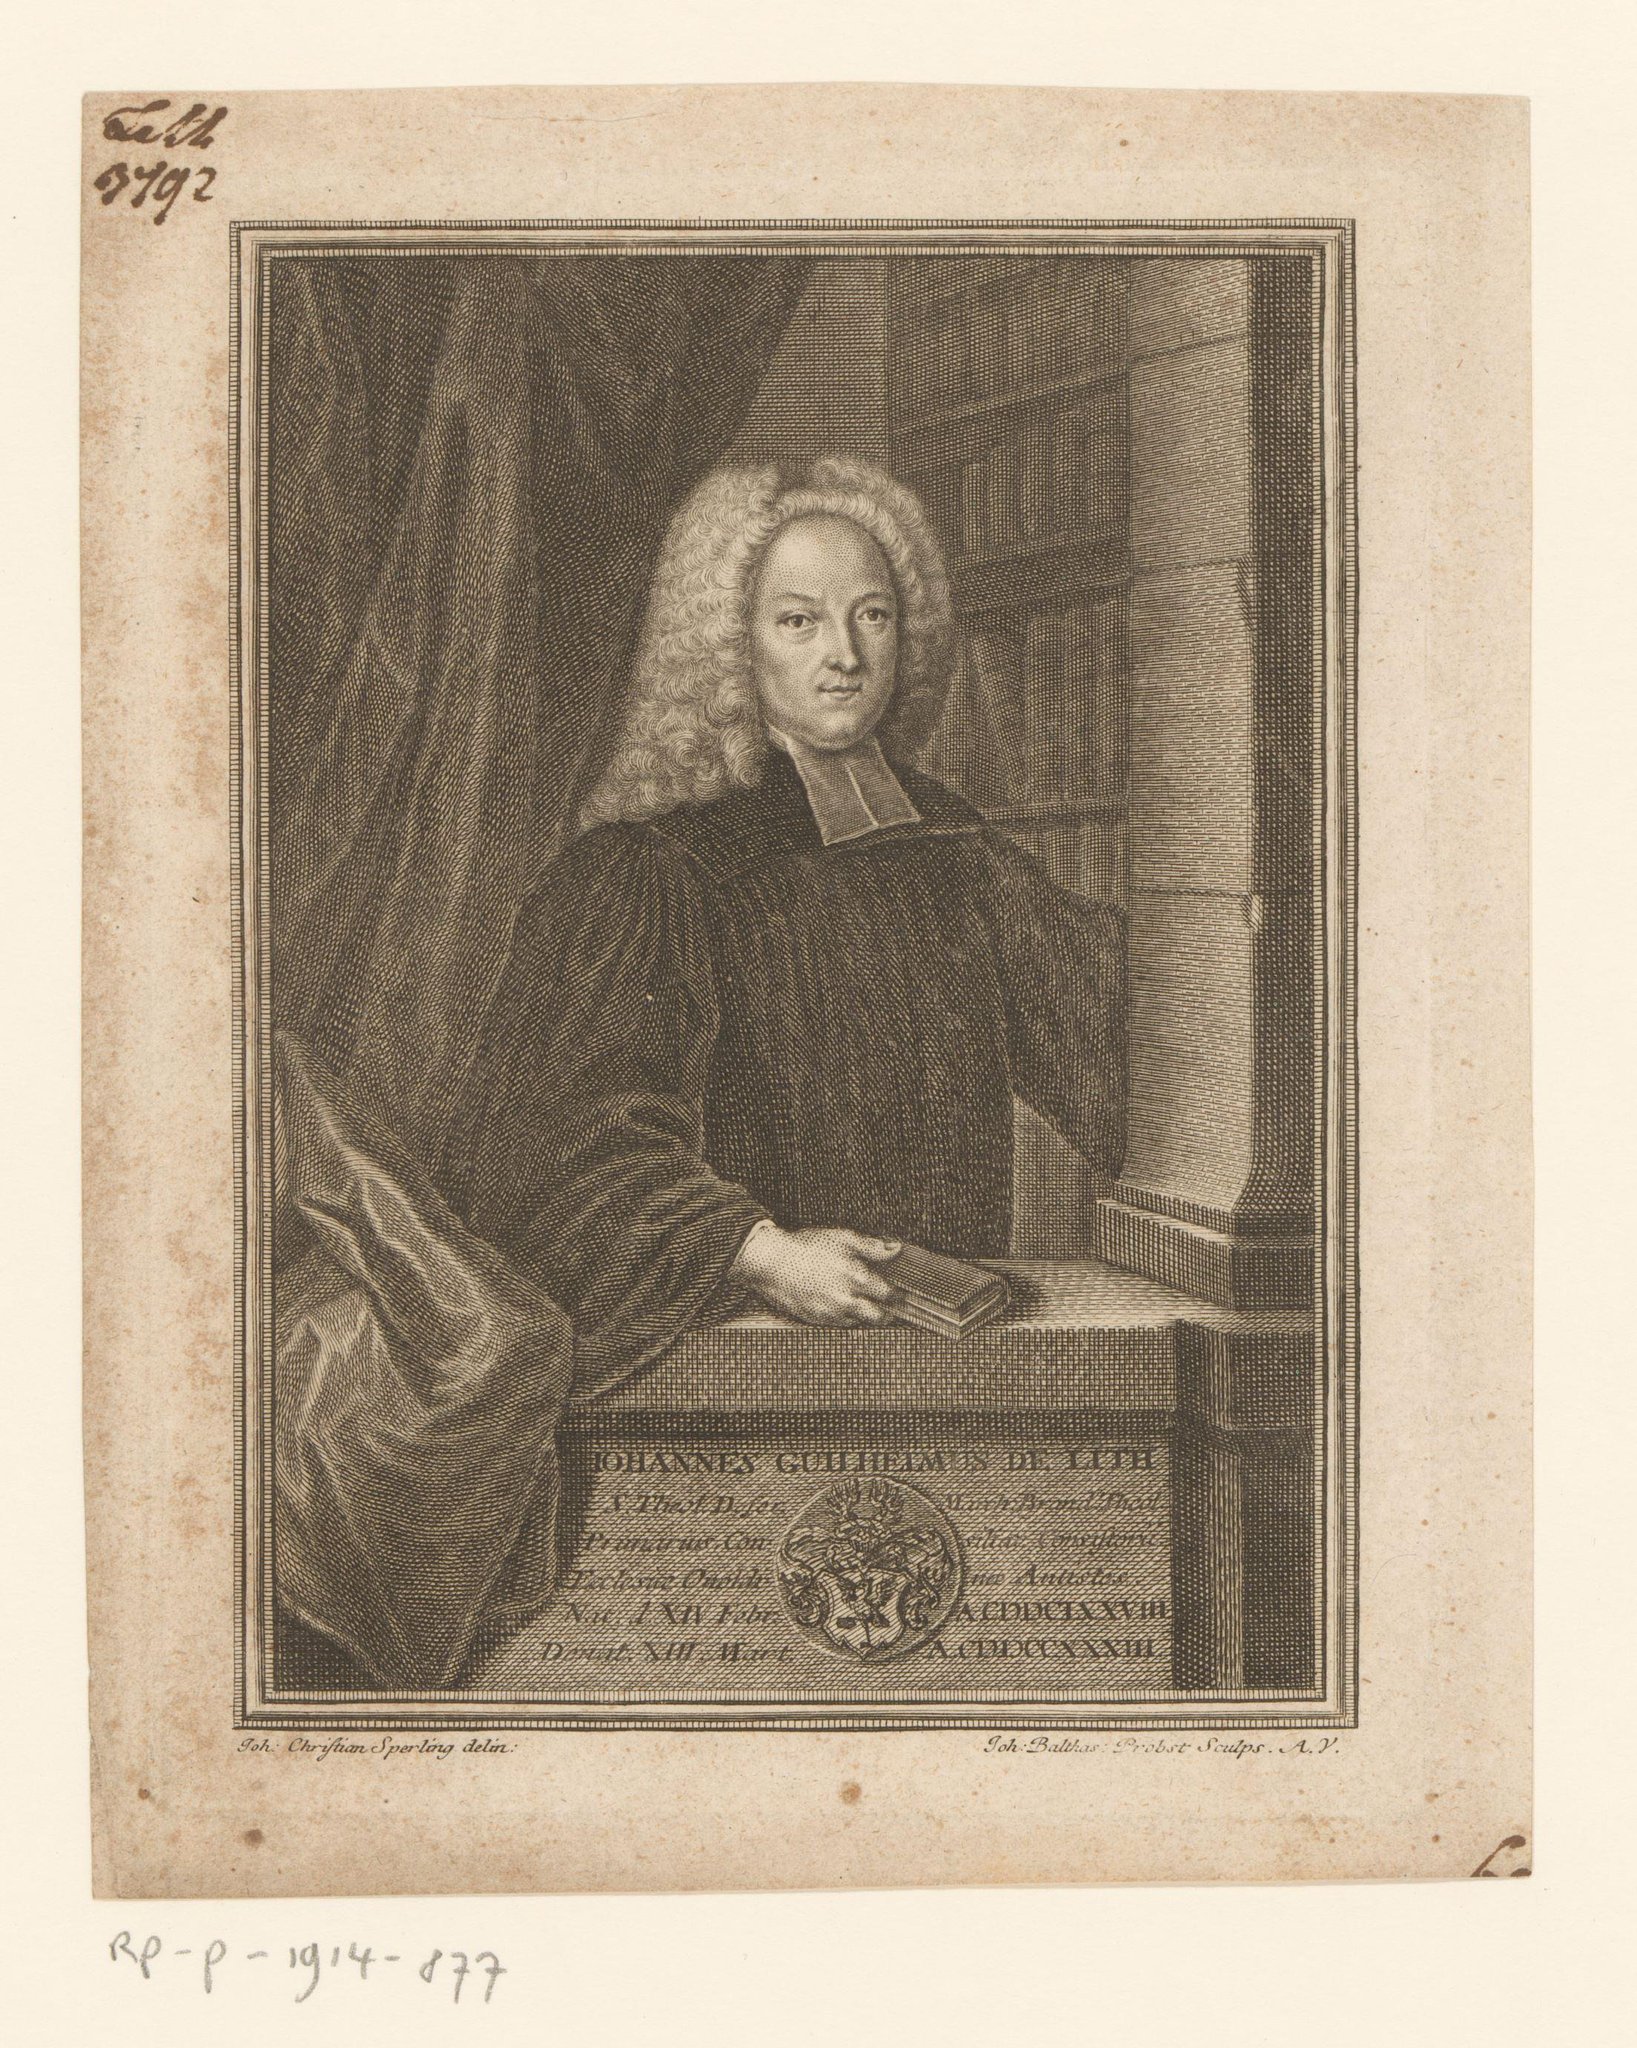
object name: print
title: Portret van Johann Wilhelm von der Lith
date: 1693-1750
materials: paper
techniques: engraving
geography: augsburg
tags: bookshelves, historical persons, book, armorial bearing, heraldry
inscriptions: collector's mark: Lugt 2228